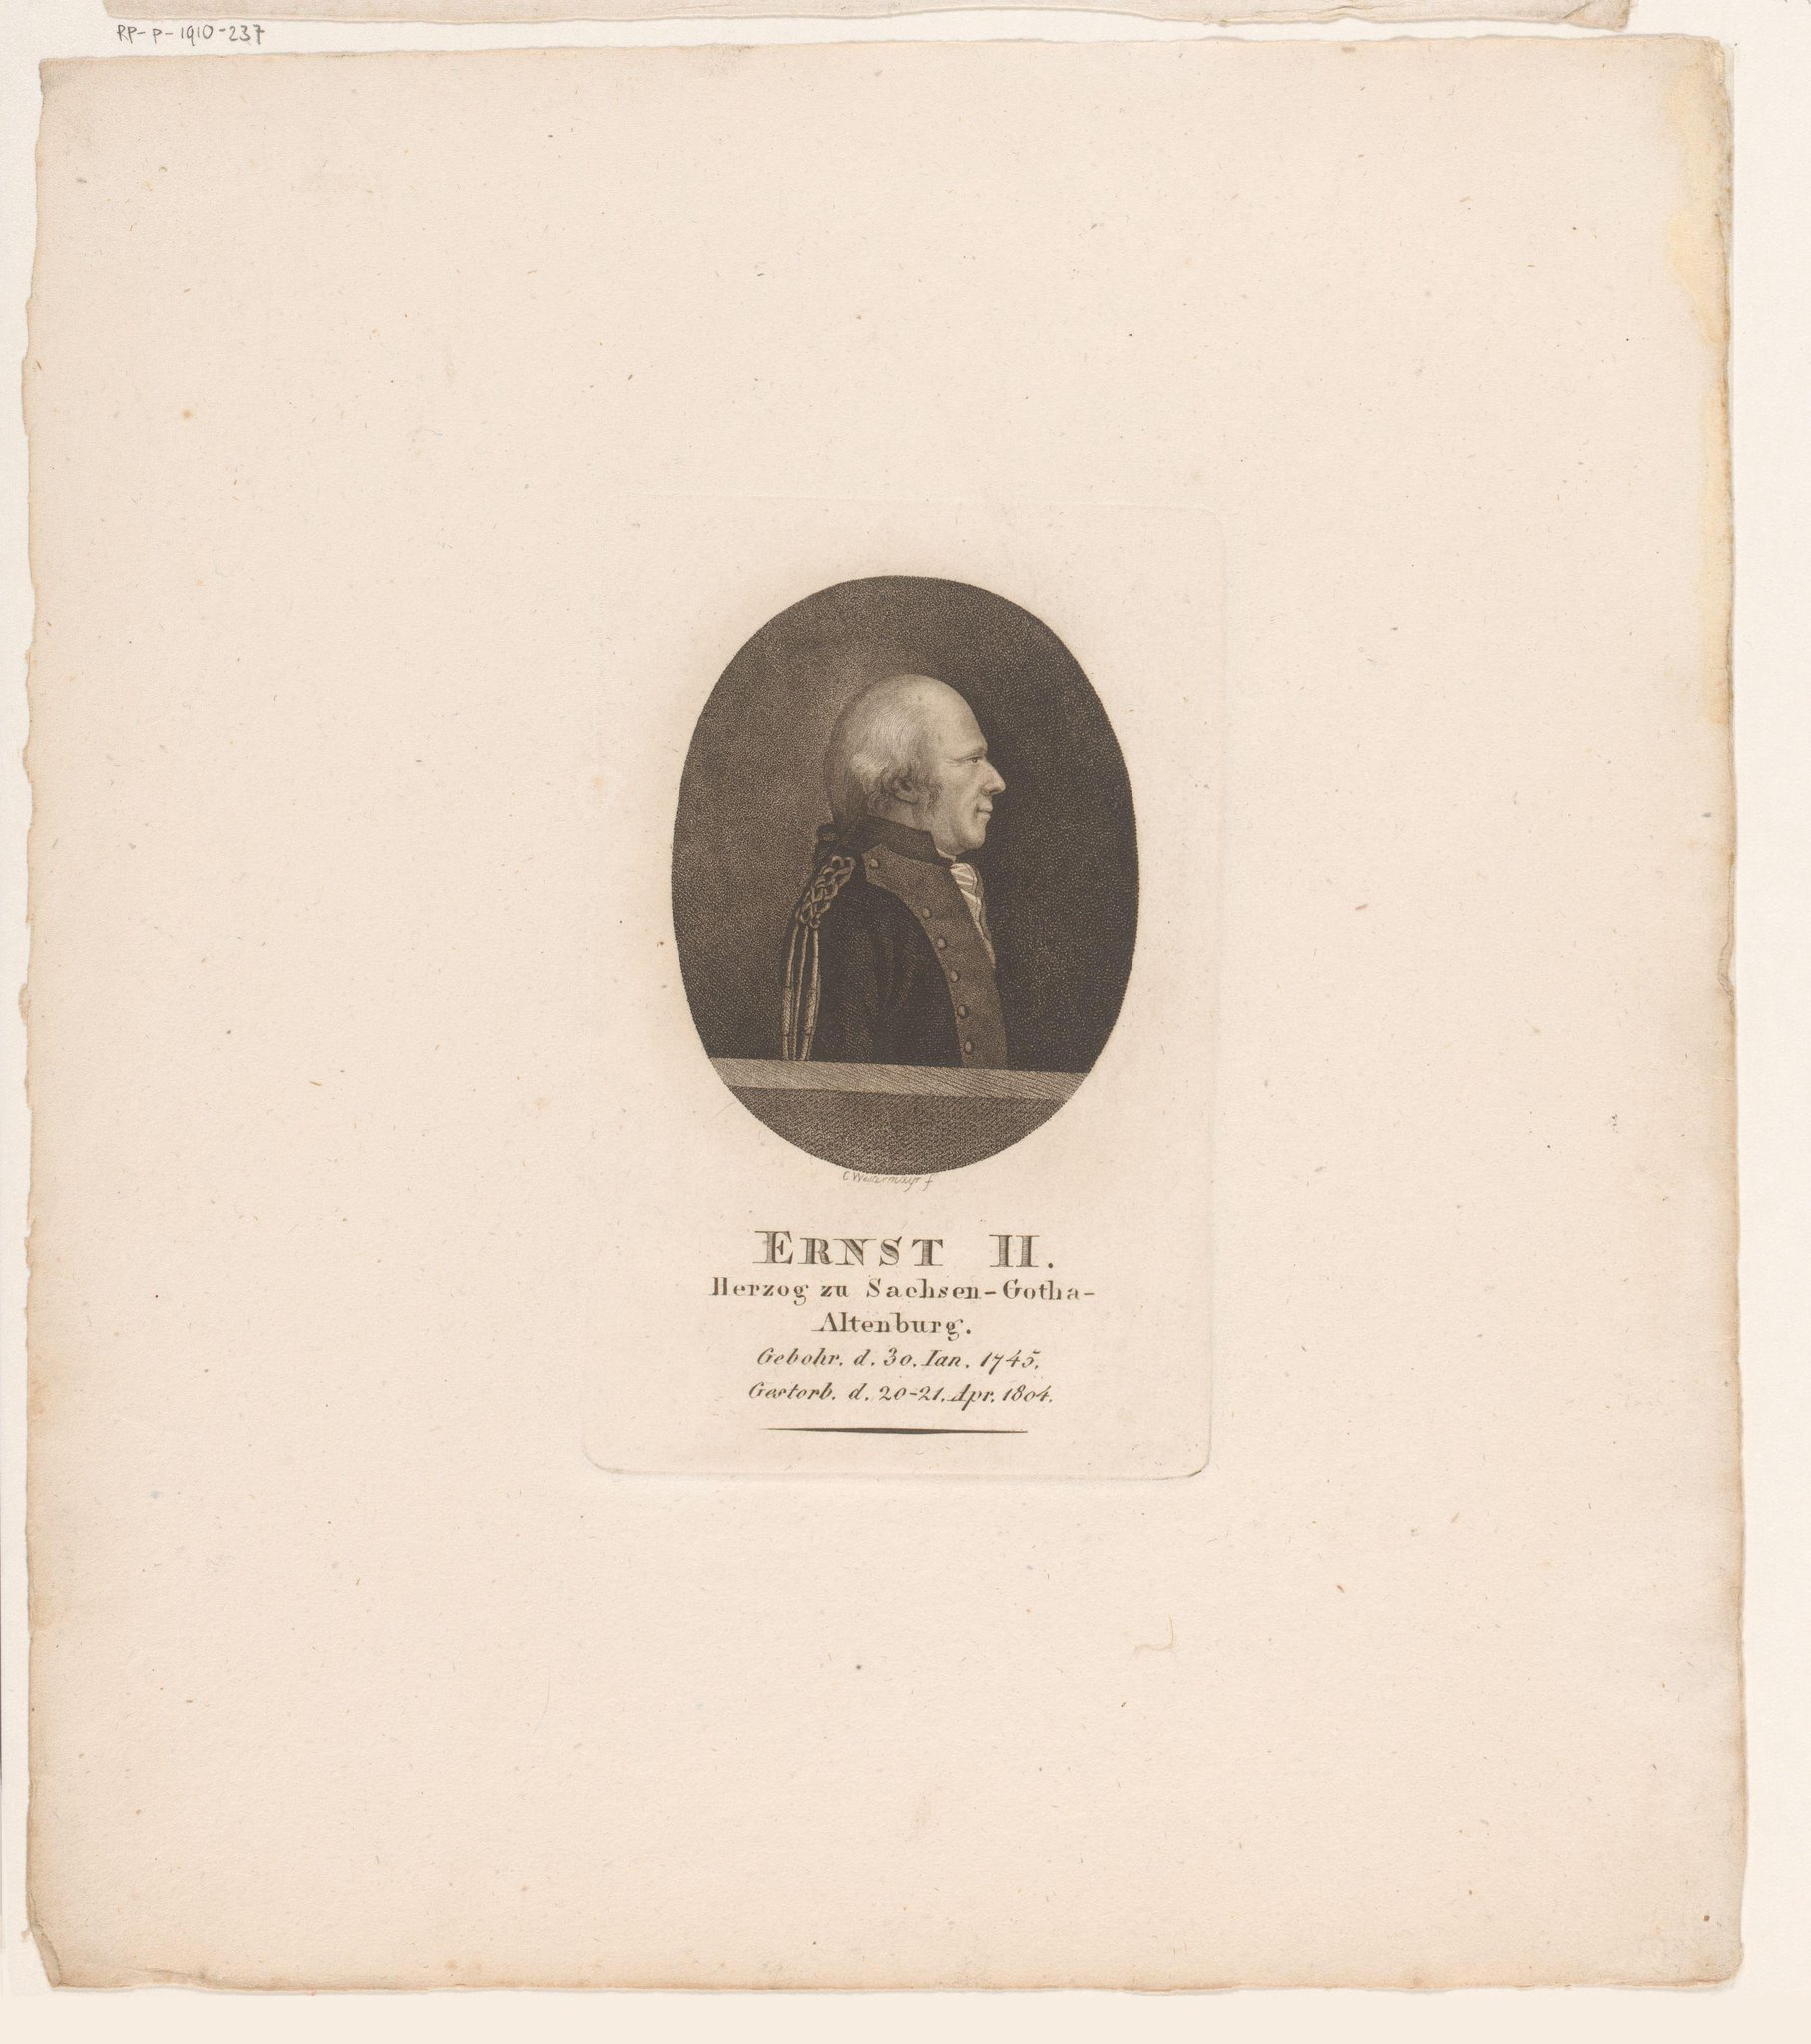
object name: print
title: Portret van Ernst II, hertog van Saksen-Gotha-Altenburg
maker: konrad westermayr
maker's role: print maker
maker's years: 1765-1834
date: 1775-1834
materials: paper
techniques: engraving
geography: germany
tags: historical persons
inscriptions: collector's mark: Lugt 2228